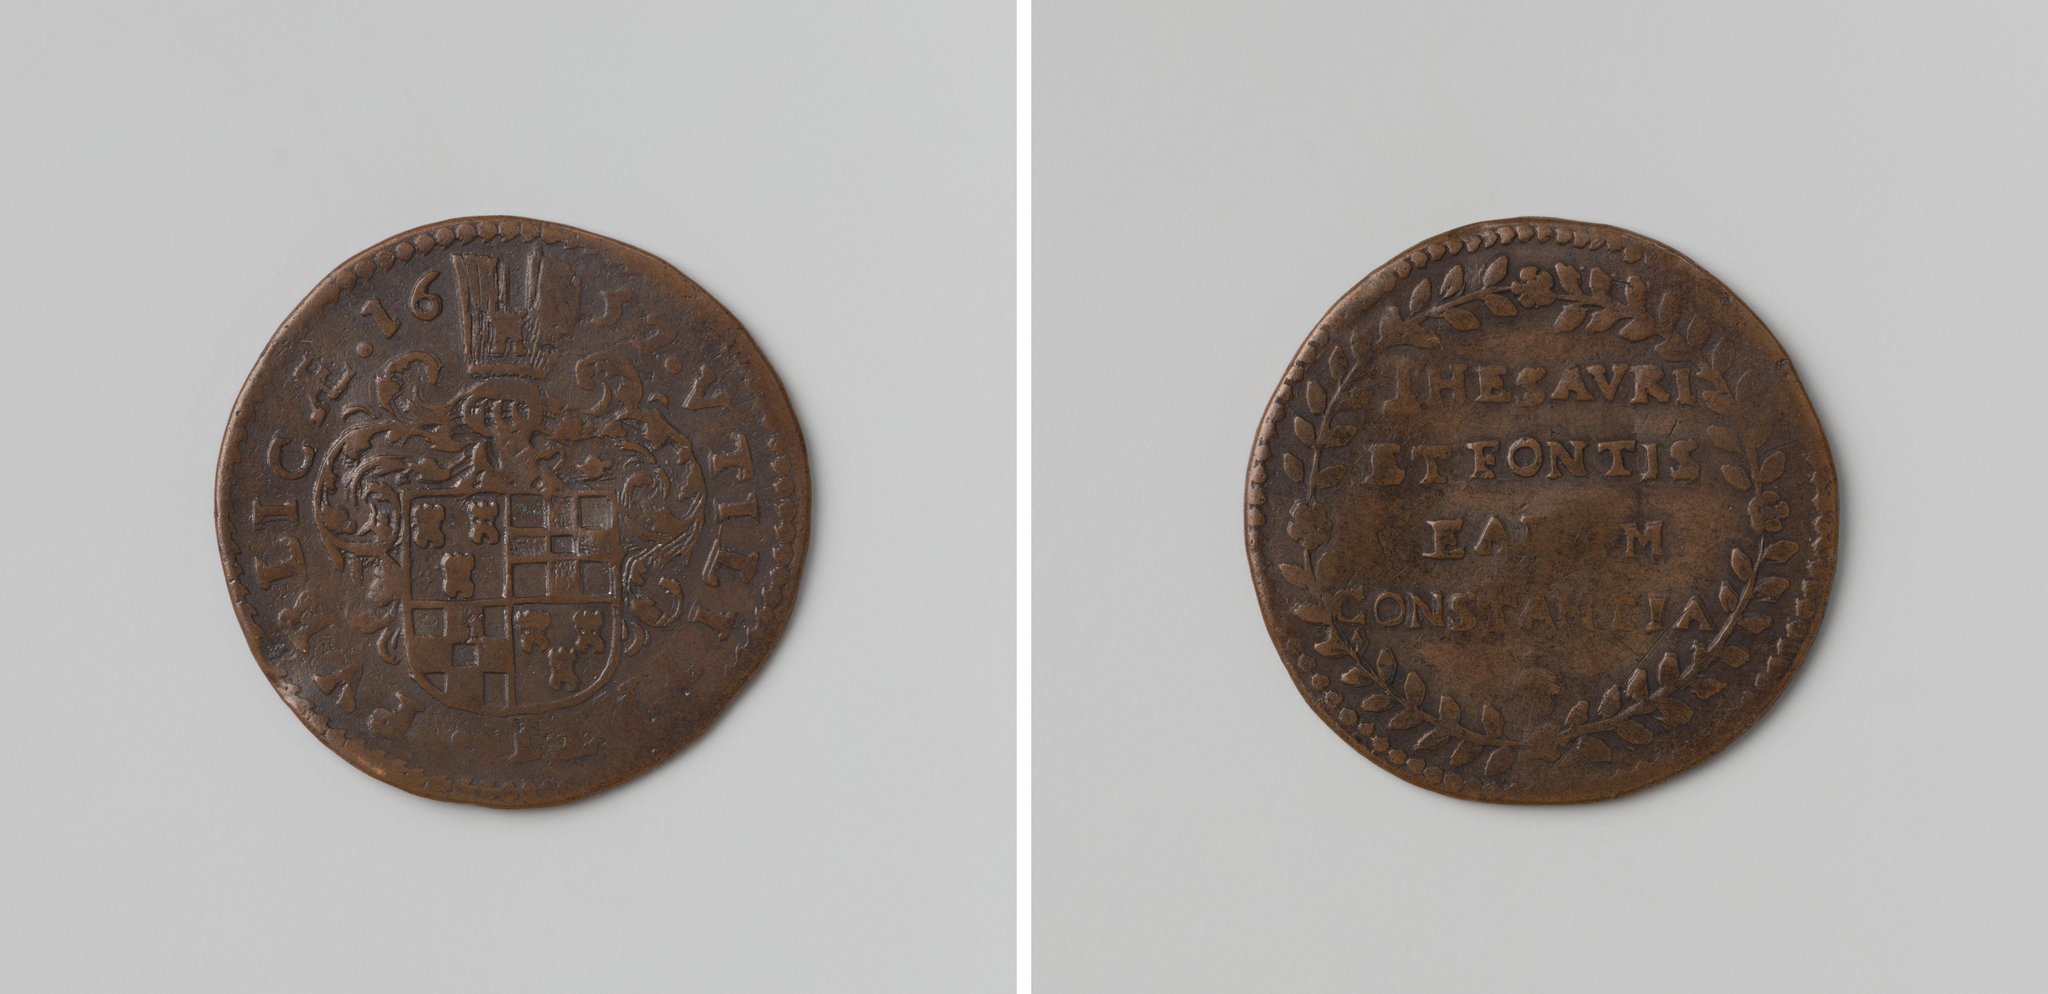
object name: jeton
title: Jean van den Hecke, magistraat van de schatkist van Brussel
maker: Anonymous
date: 1601-1657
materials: copper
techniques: striking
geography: brussels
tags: brussels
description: Koperen penning. Voorzijde: gehelmd wapenschild binnen omschrift. Keerzijde: opschrift binnen lauwerkrans